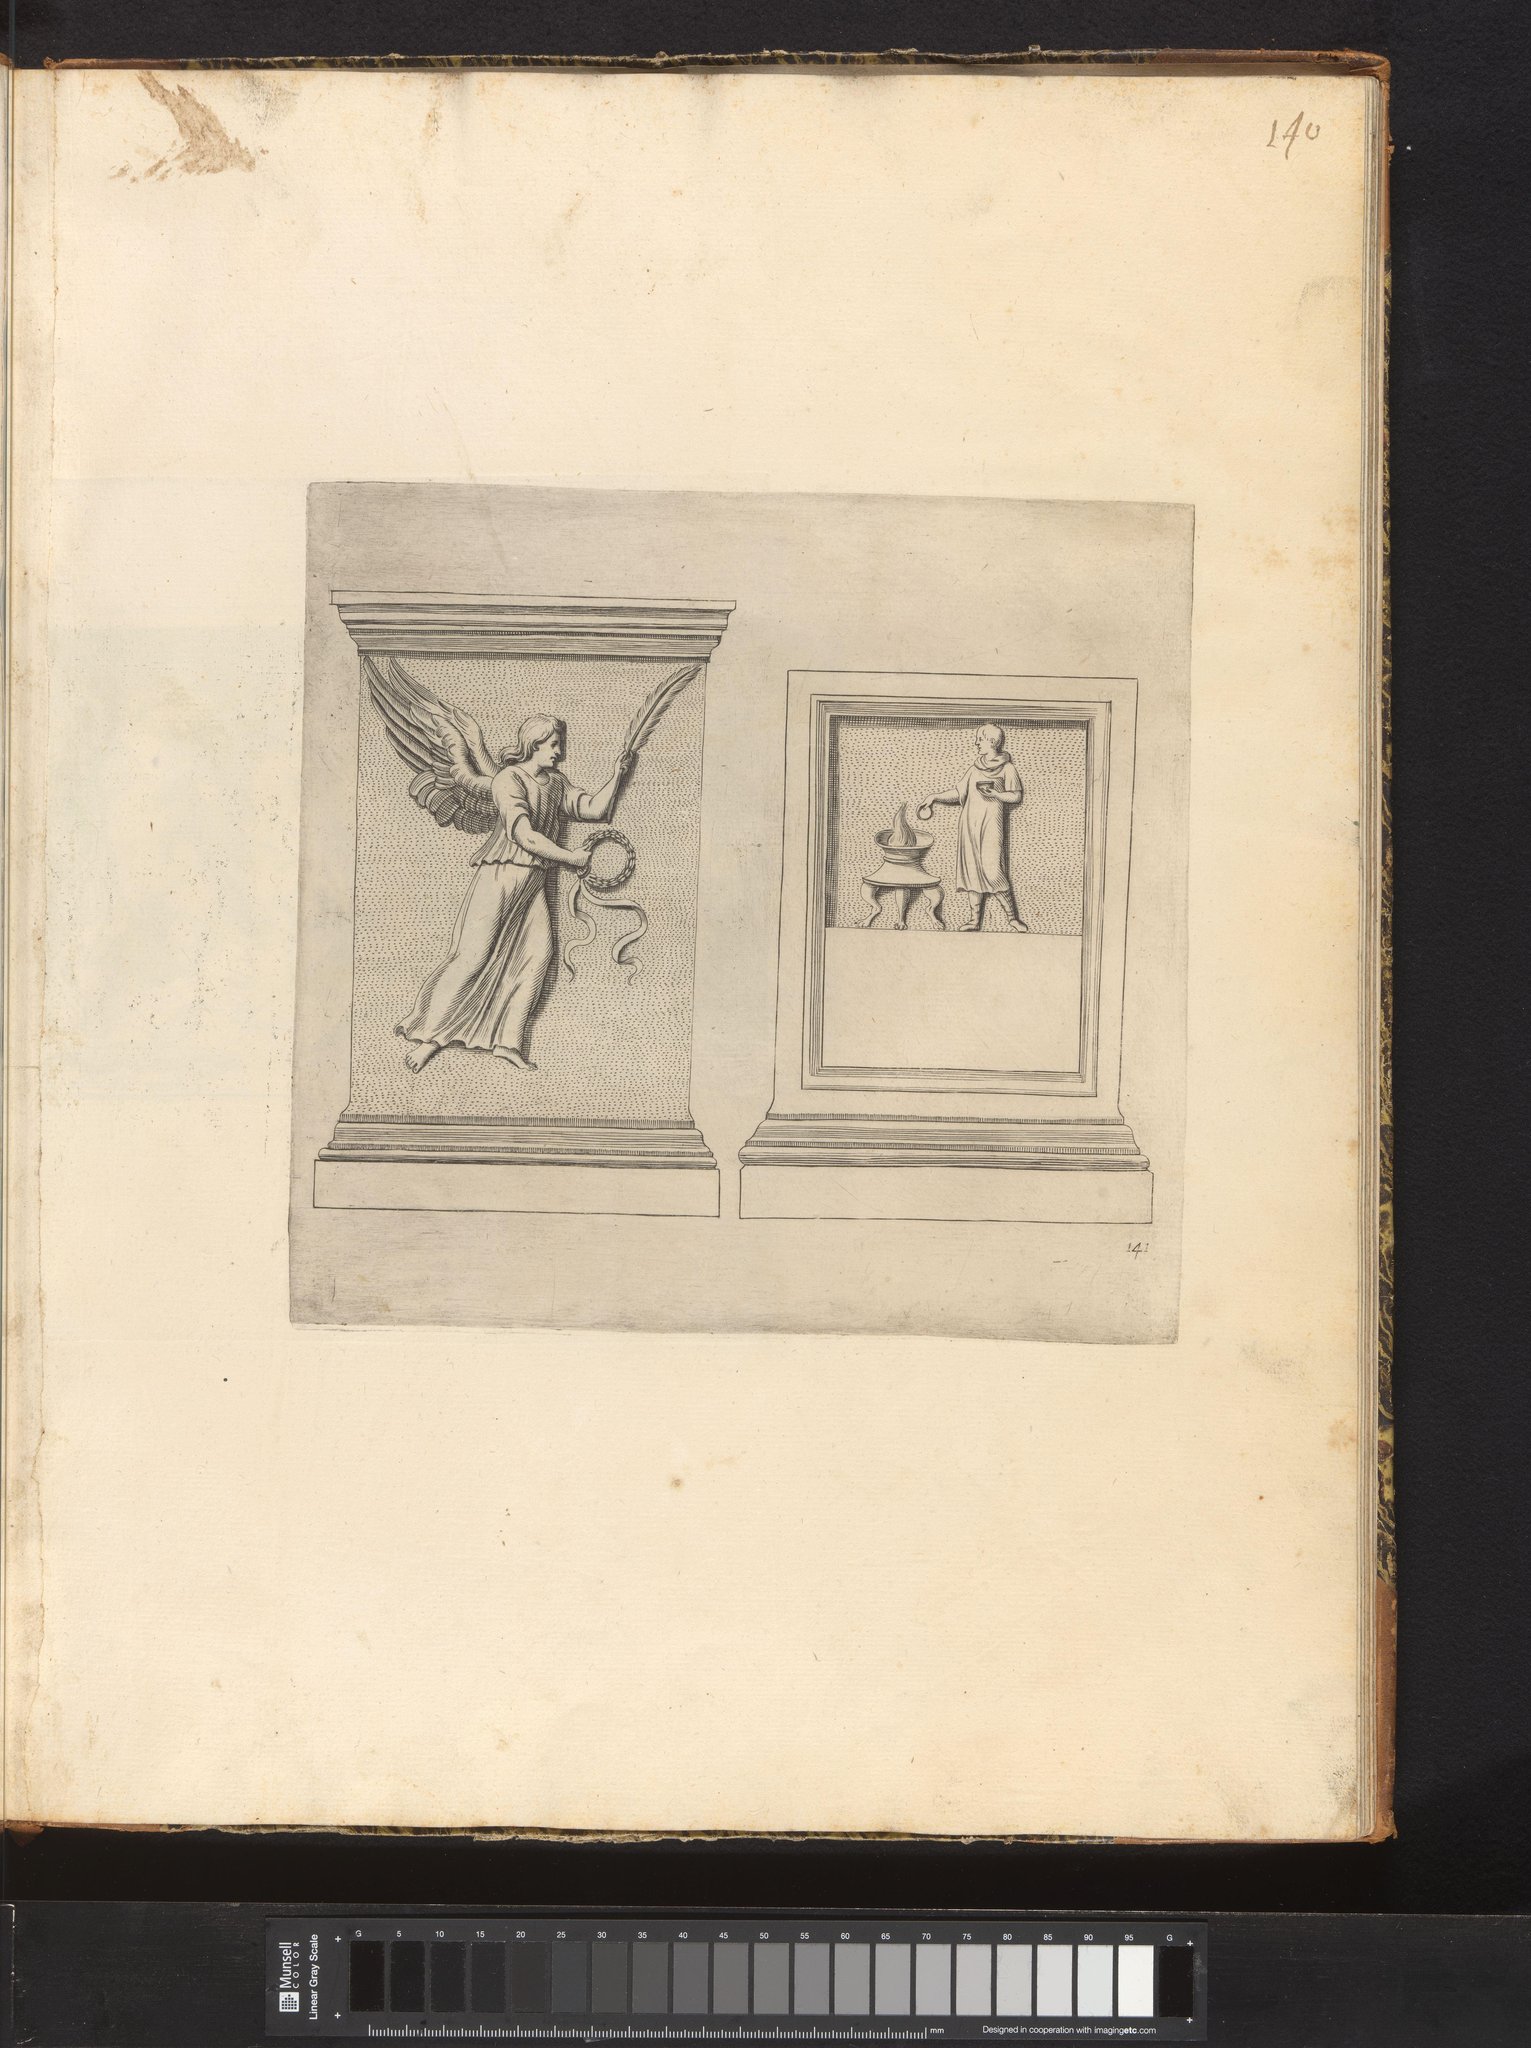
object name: print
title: Galleria Giustiniana del Marchese Vincenzo Giustiniani II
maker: matthäus greuter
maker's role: print maker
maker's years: 1564-1638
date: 1636-1647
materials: paper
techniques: engraving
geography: rome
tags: nereids, daughters of nereus; sea-nymphs, gods of the waters: neptune and his environment, piece of sculpture, reproduction of a piece of sculpture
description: Bas-reliëf met een triomftocht van Nereïden en Tritons. Midden onder het wapenschild van Vincenzo Giustiniani. Prent maakt deel uit van een album met een serie prenten naar de sculpturen in de verzameling in de Galleria Giustiniani te Rome.